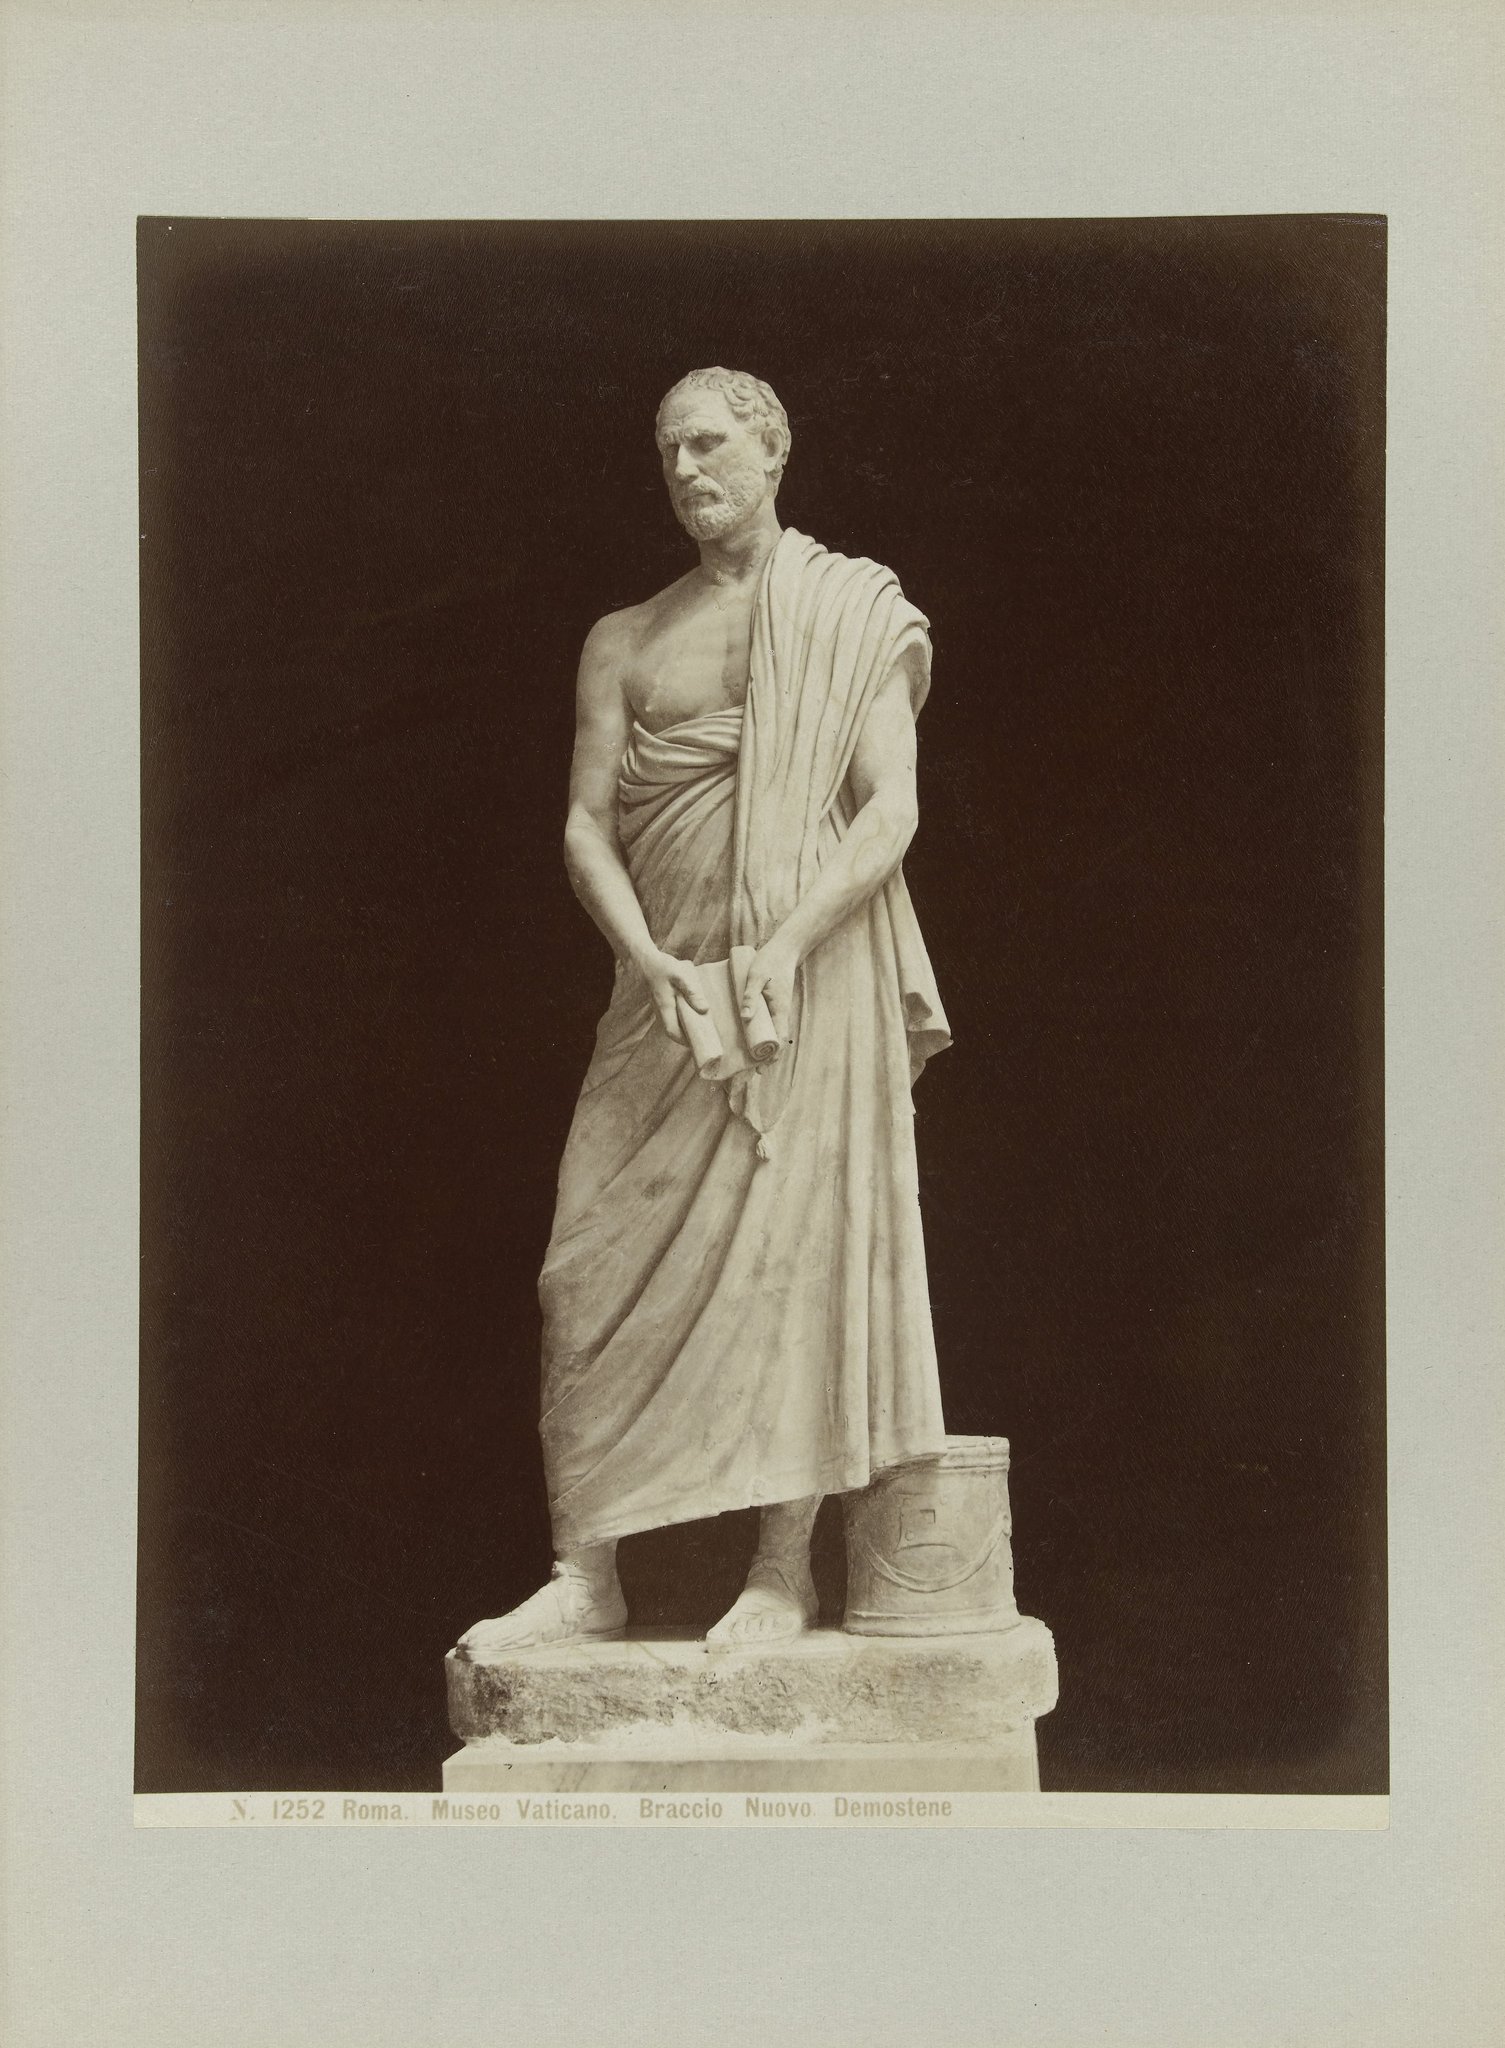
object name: photograph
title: N. 1252 Roma. Museo Vaticano. Braccio Nuovo. Demostene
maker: Anonymous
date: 1880-1904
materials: cardboard, paper, photographic support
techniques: albumen print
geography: rome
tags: vaticaanse musea